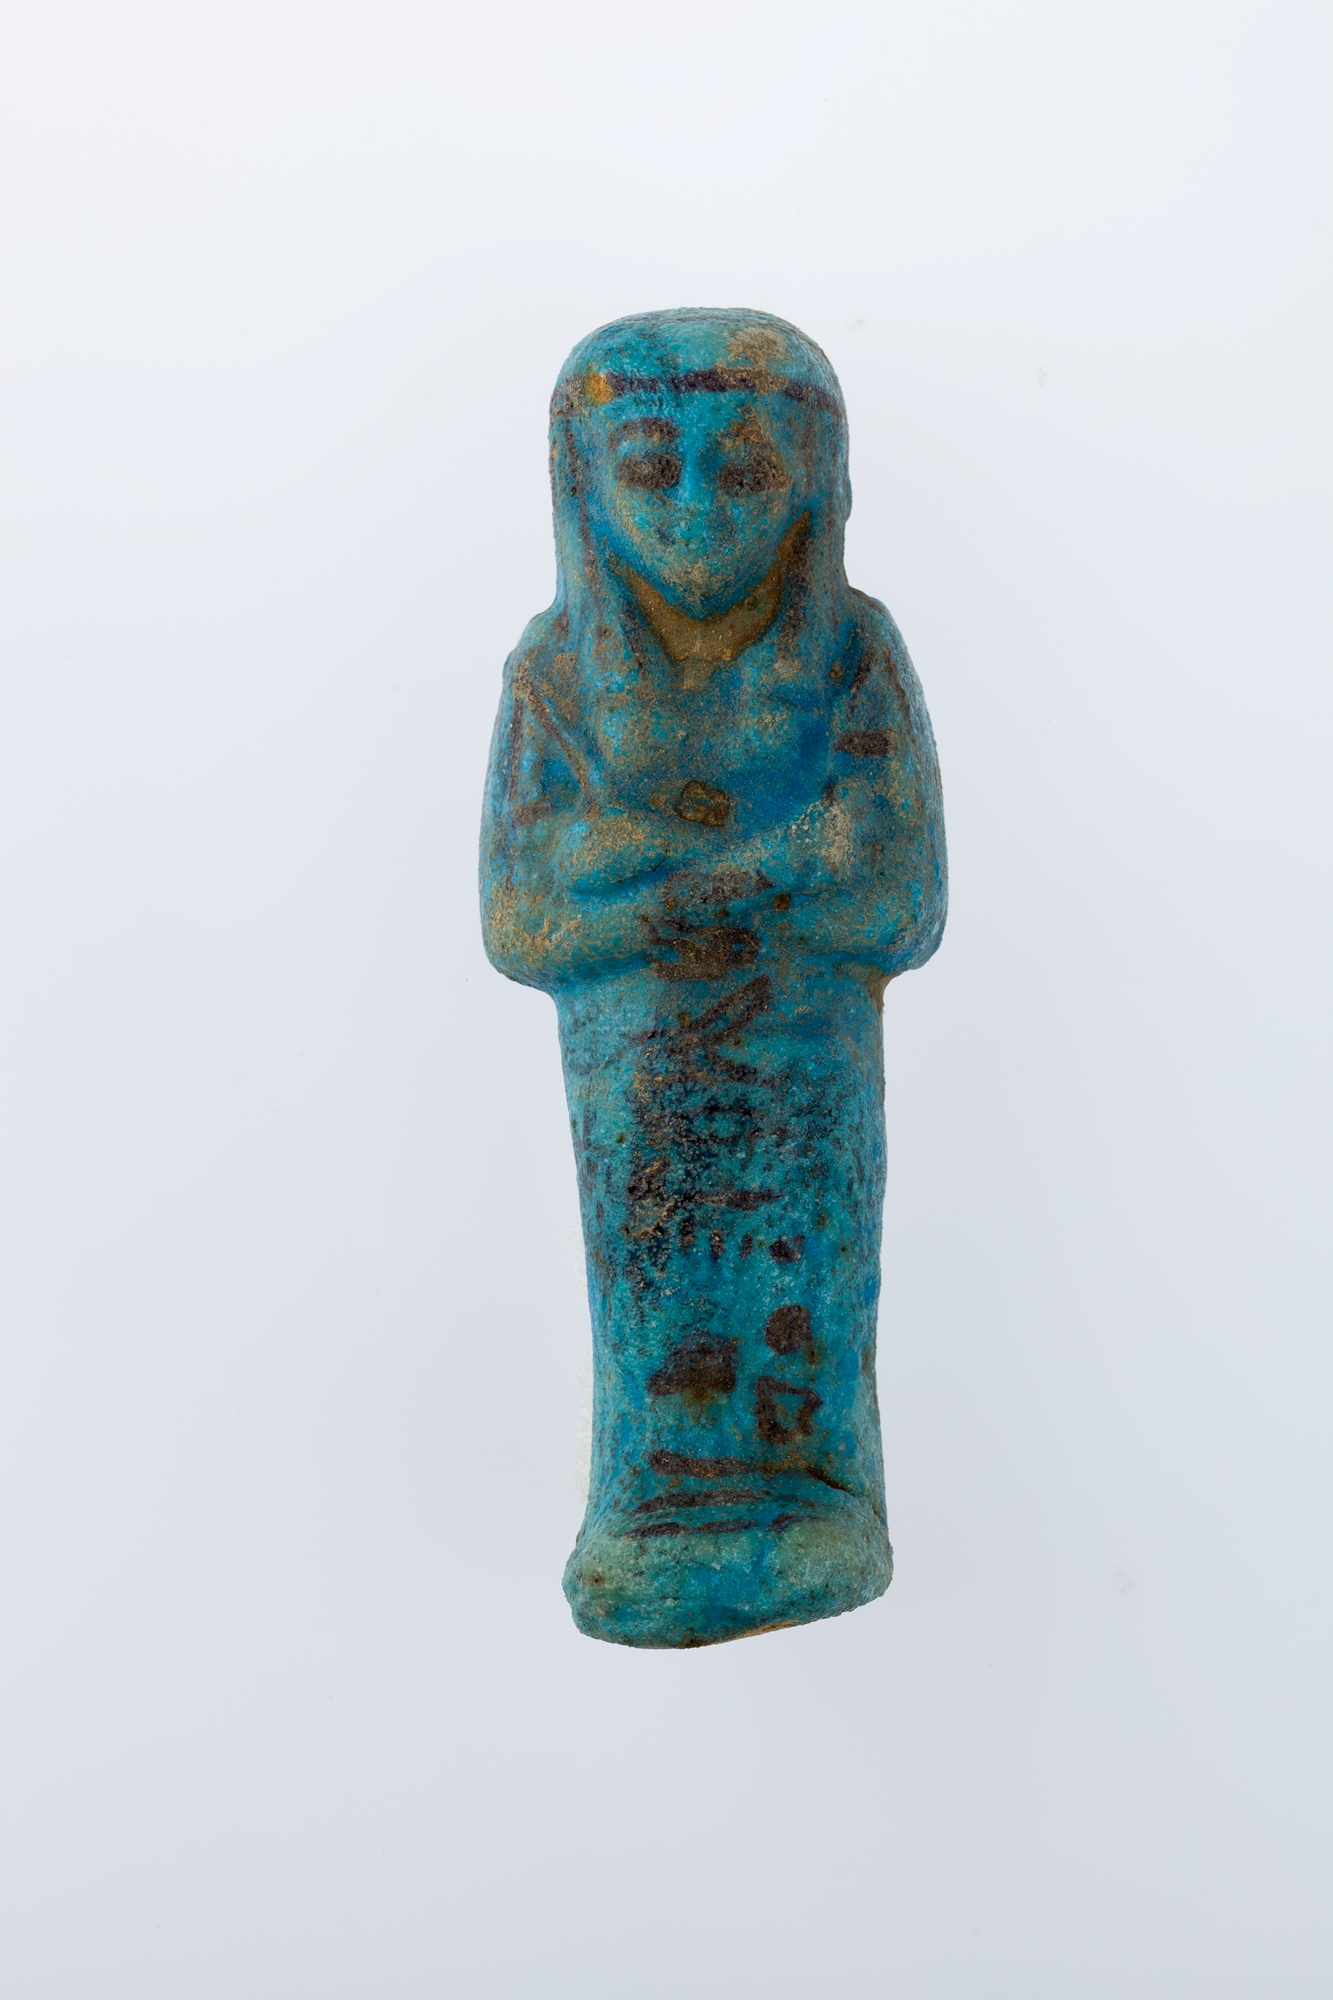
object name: shabti, henettawy c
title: Worker Shabti of Henettawy (C), Daughter of Isetemkheb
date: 990-970 BCE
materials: faience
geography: egypt